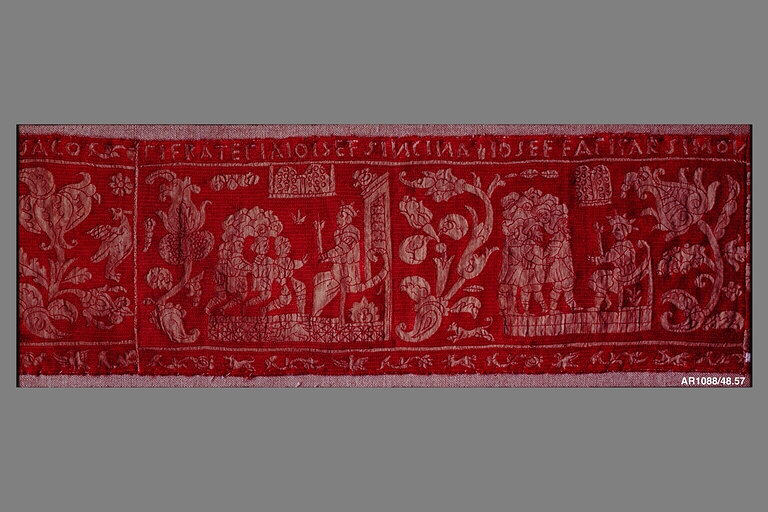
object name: strip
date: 1501-1600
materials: linen, silk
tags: human figures,animals,flowers